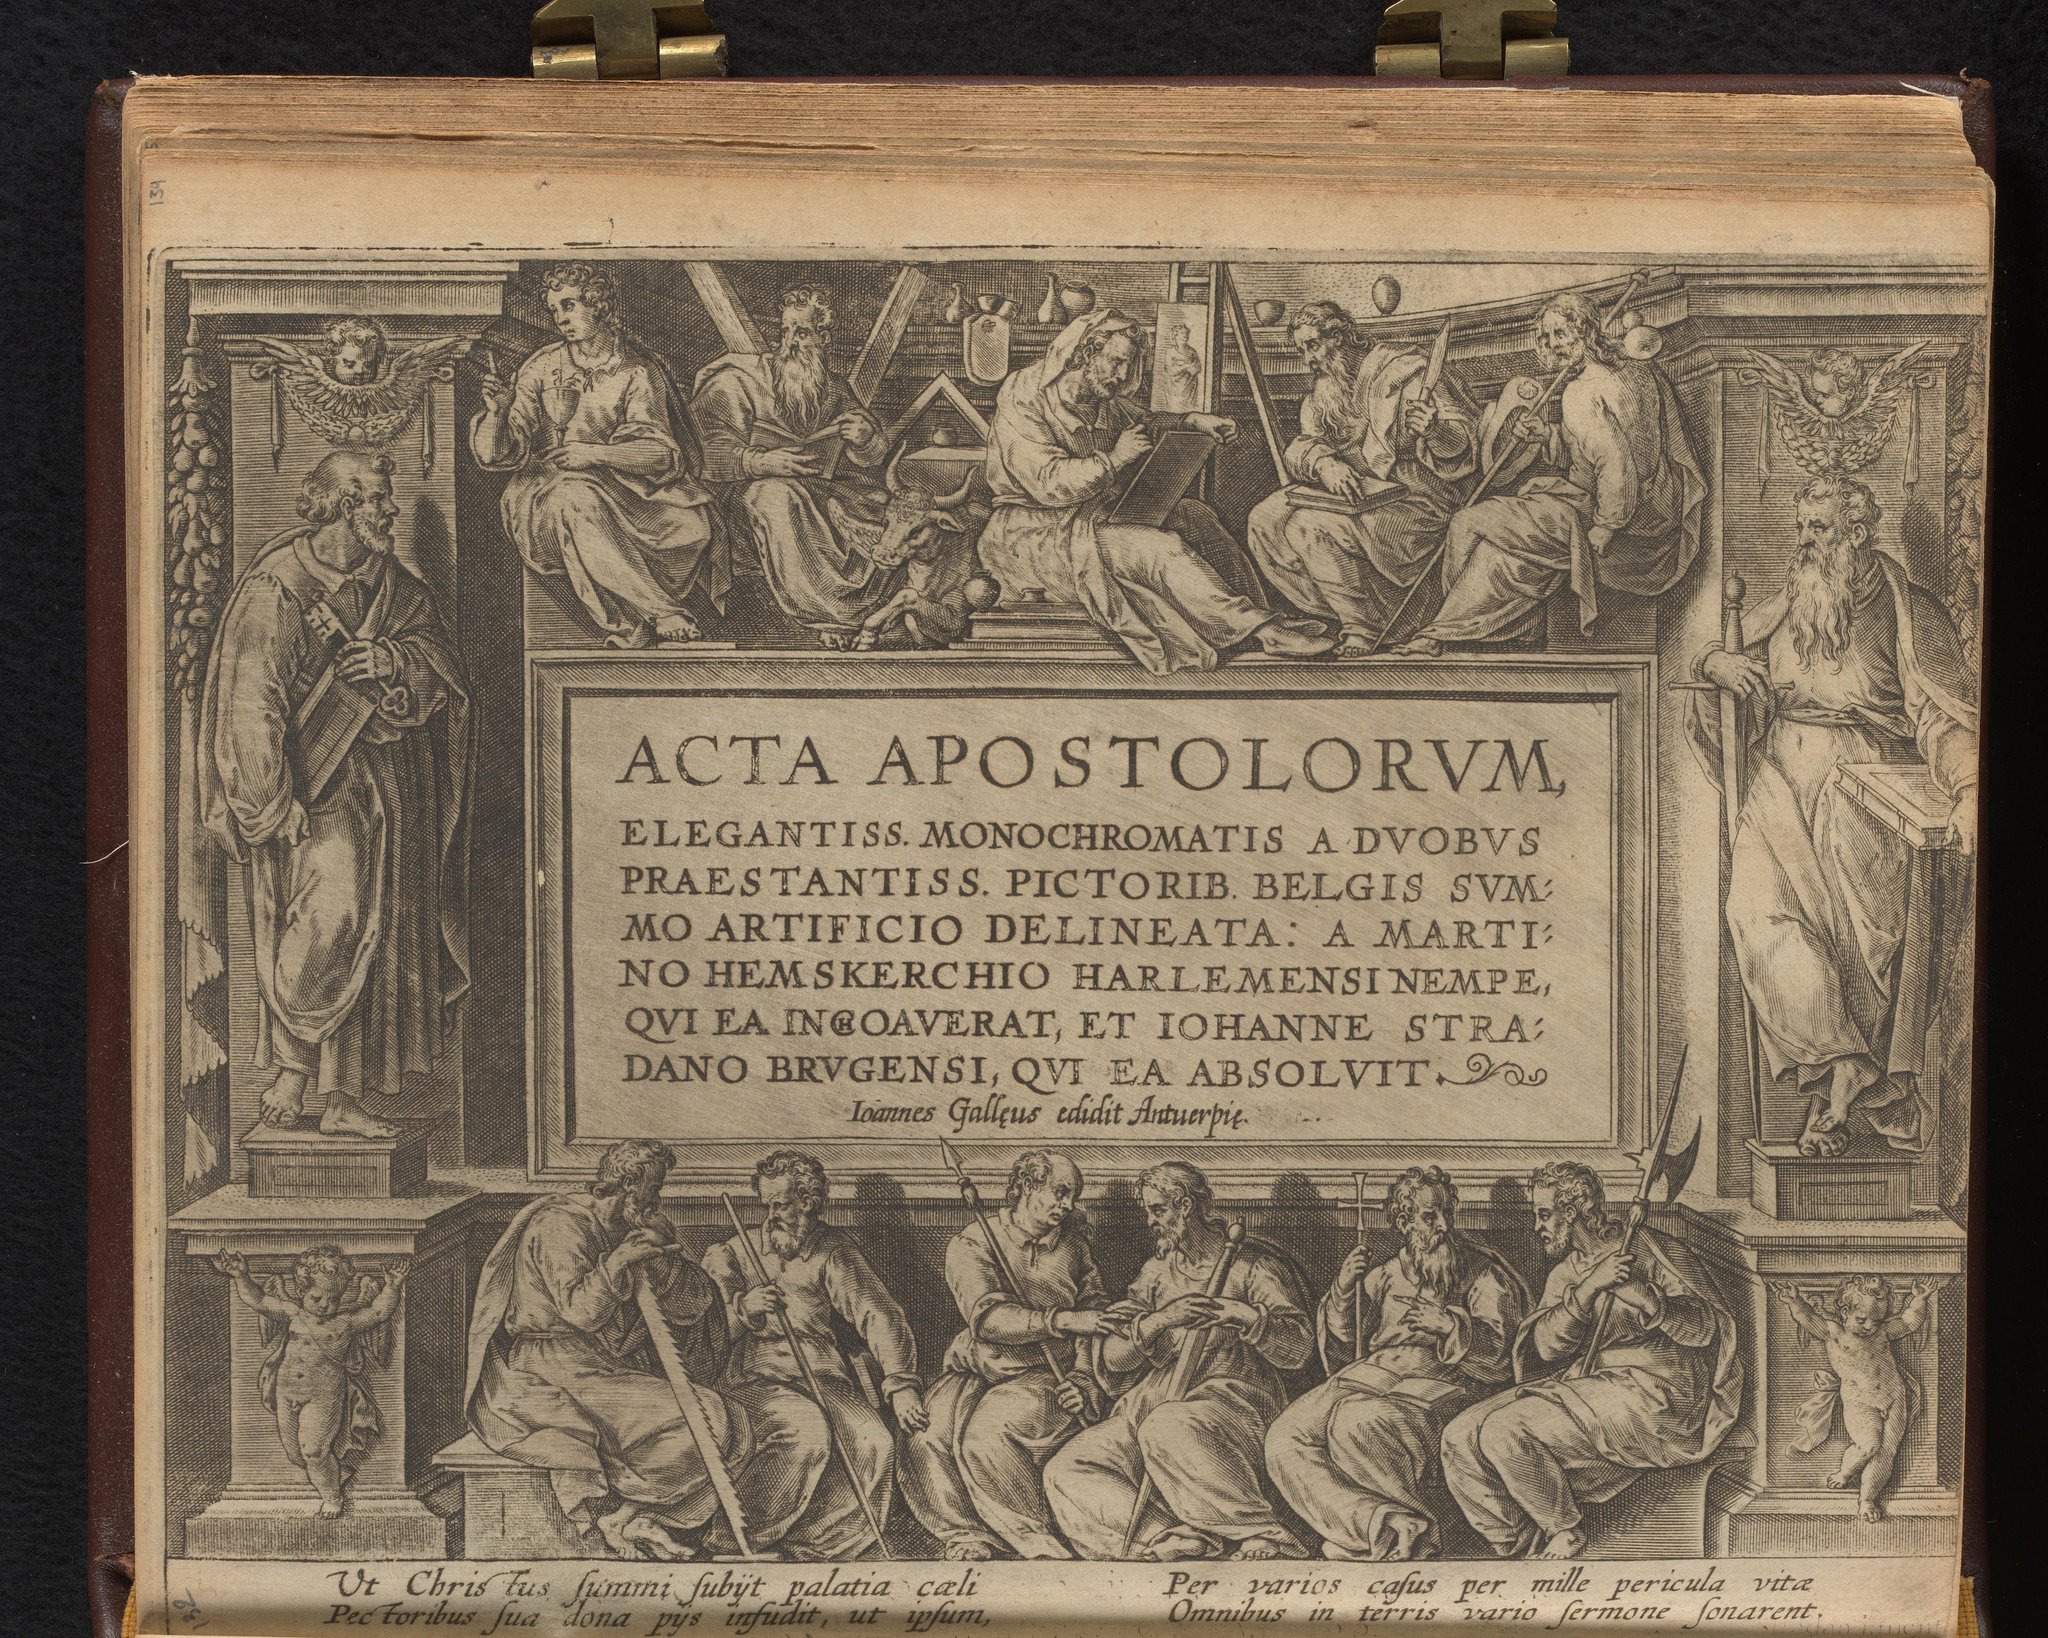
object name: album leaf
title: Titelprent voor een serie over de handelingen van de apostelen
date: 1582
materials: paper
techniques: engraving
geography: antwerp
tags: the twelve apostles (as a group), usually with books or scrolls (not in biblical context), lives and acts of the apostles (part i)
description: Prent maakt deel uit van een prentbijbel.